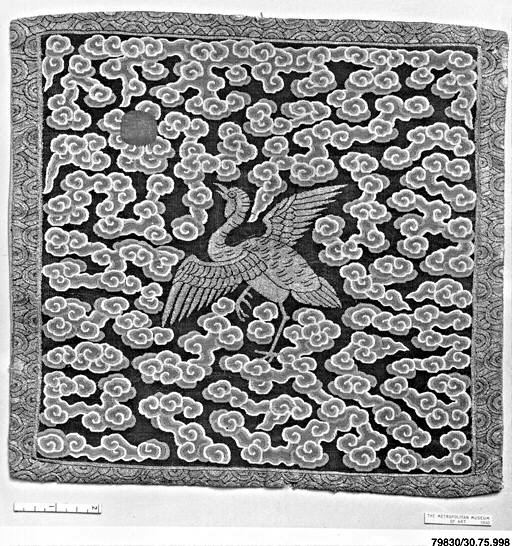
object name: rank badge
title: Rank Badge with Wild Goose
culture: chinese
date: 1801-1900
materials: metal thread, silk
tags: geese